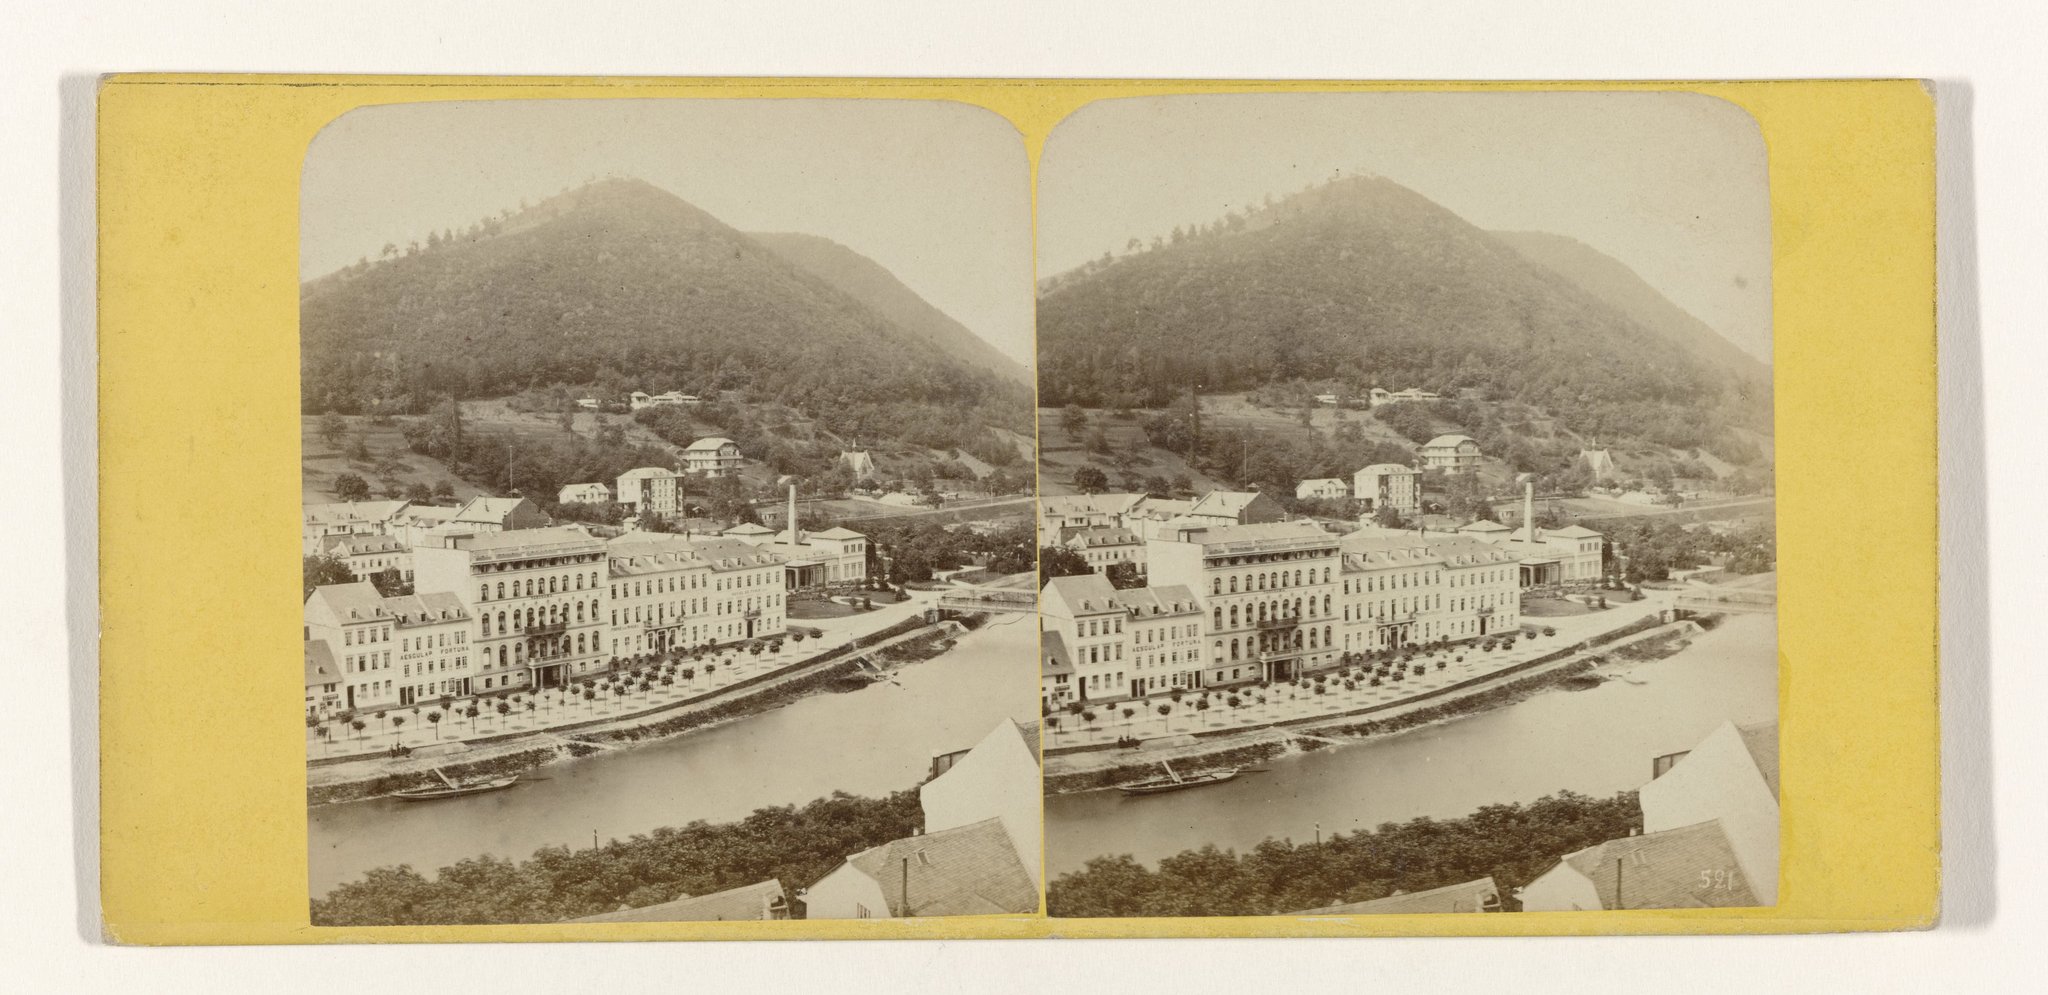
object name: stereograph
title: Gezicht op Bad Ems, Duitsland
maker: Anonymous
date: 1852-1863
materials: cardboard, paper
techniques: albumen print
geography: bad ems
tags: dale, valley, river, village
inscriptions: number: ‘521’, number: ‘521’